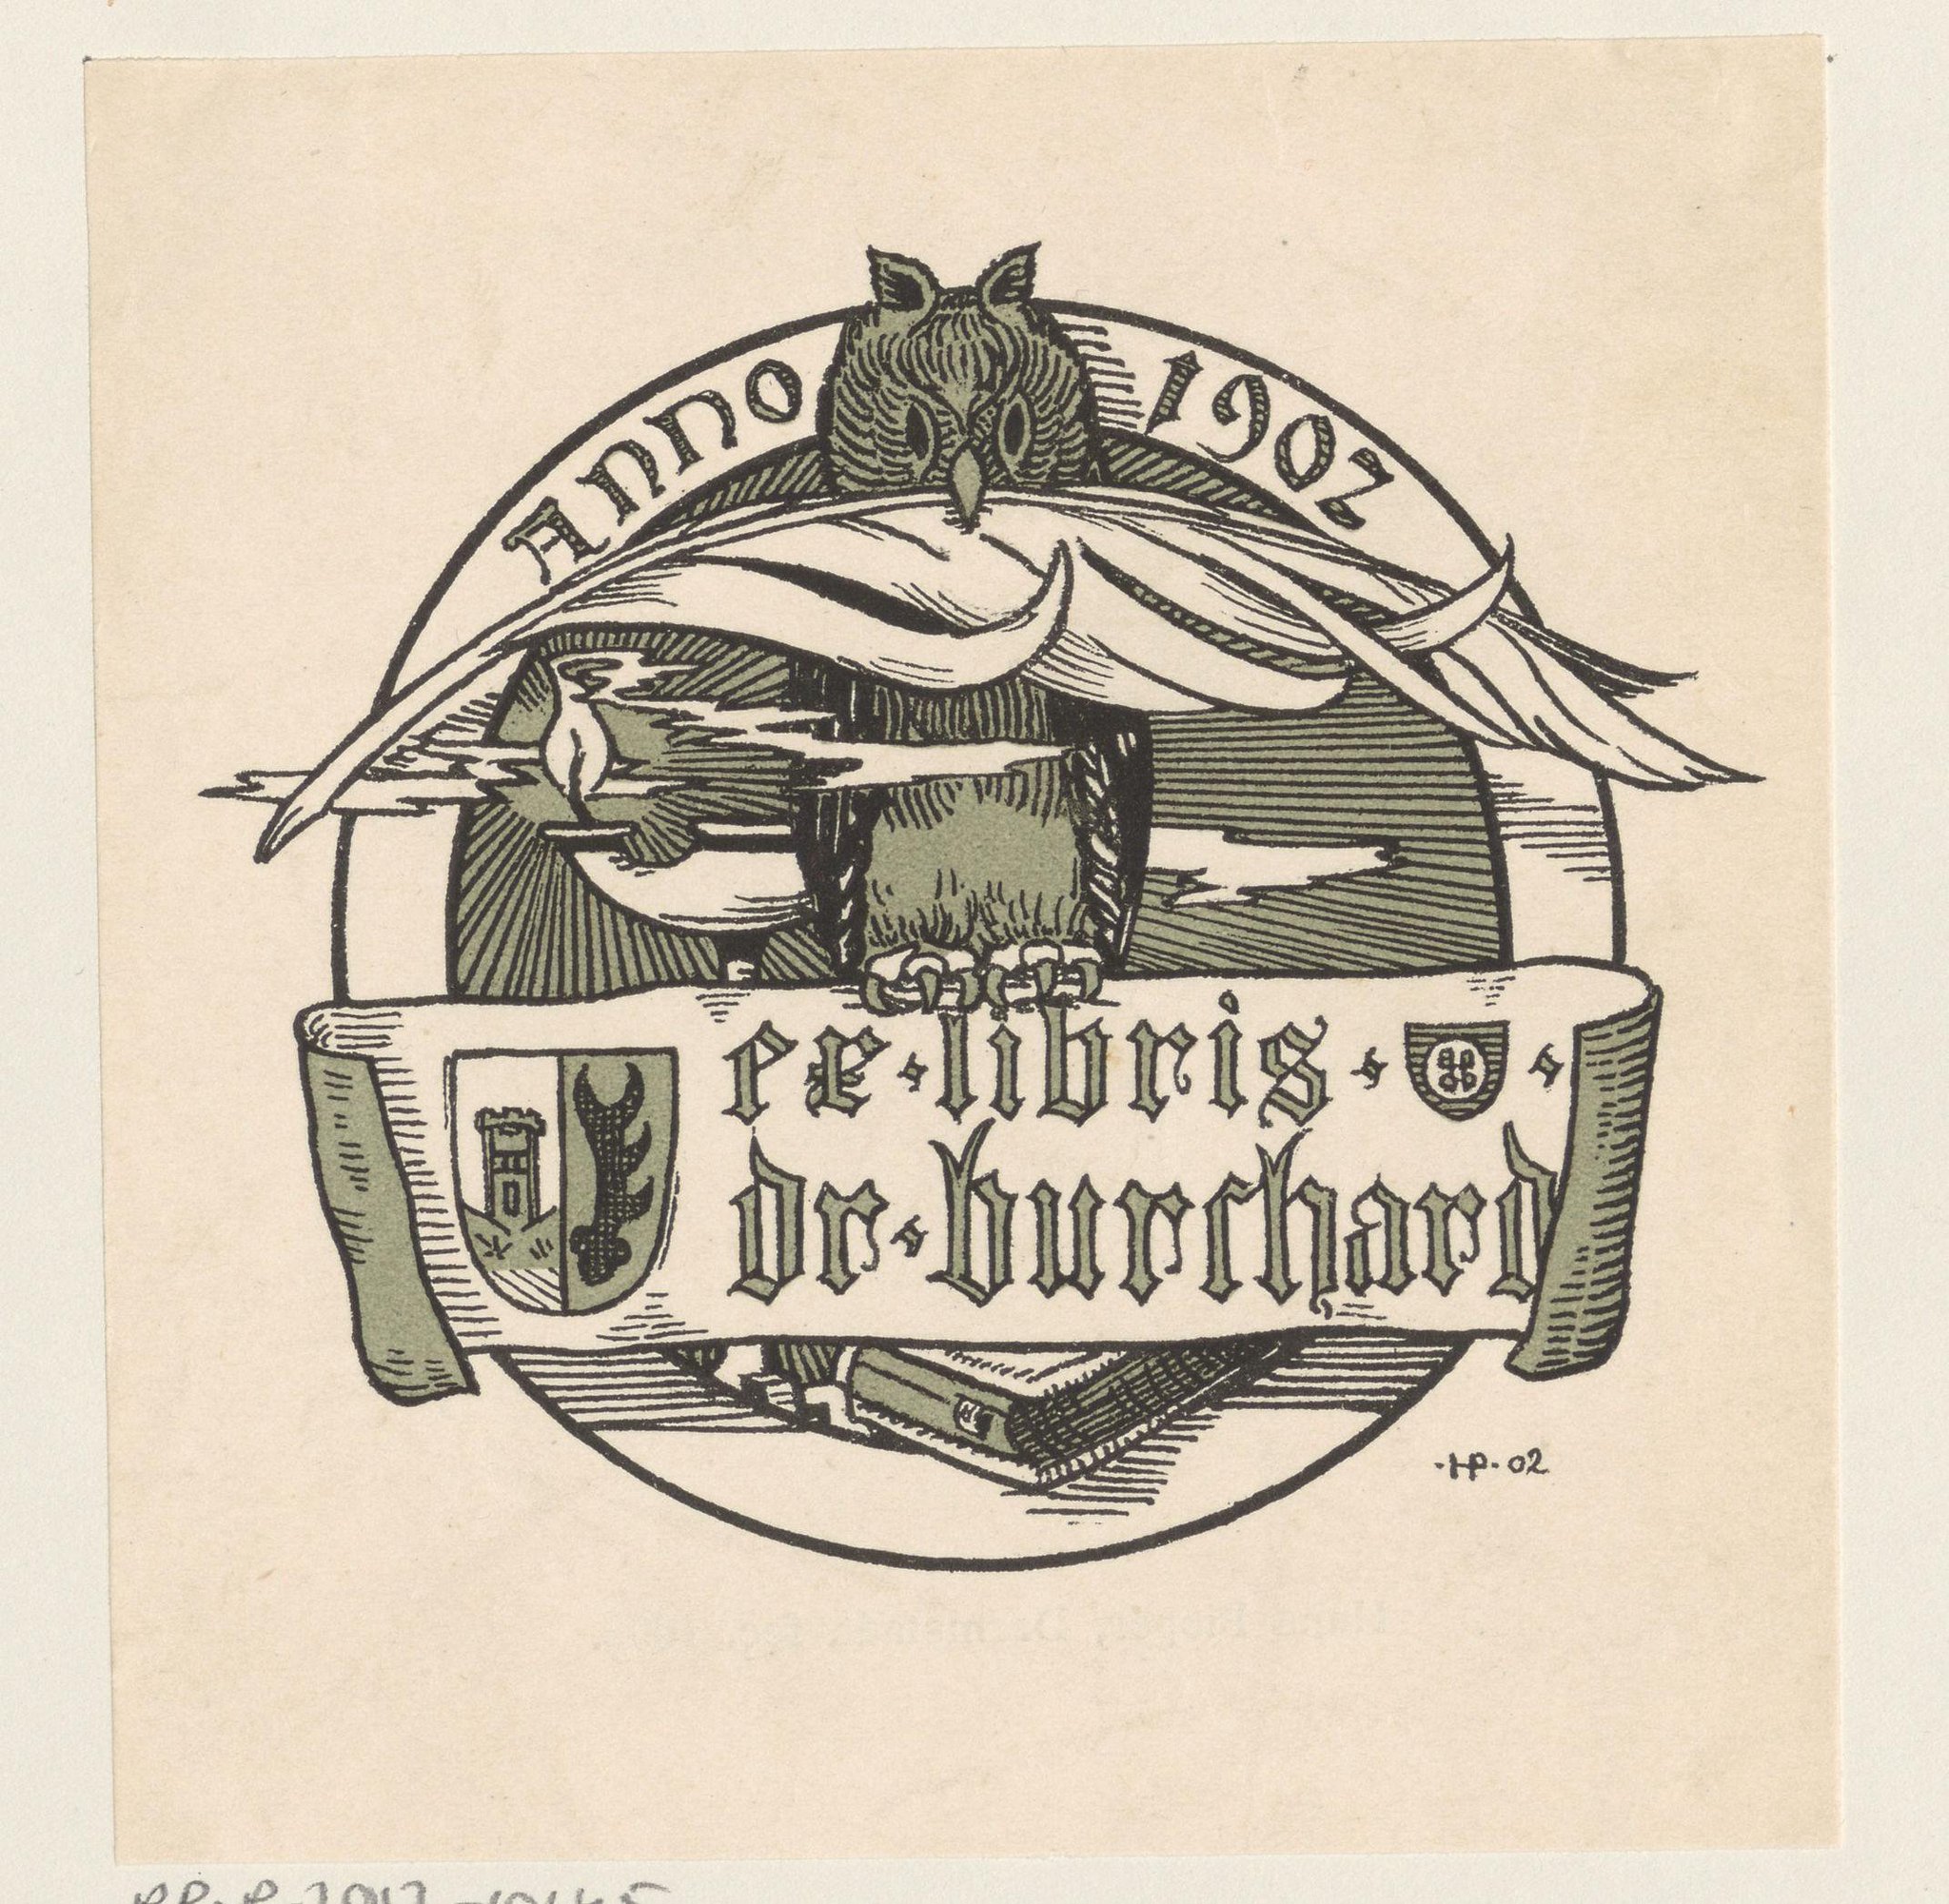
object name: bookplate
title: Ex libris van Georg Burchard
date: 1902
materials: paper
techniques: printing block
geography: darmstadt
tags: quill, oil-lamp, owls, armorial bearing, heraldry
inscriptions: inscription: ‘Hans Pieper, Darmstadt. fec. 1902’